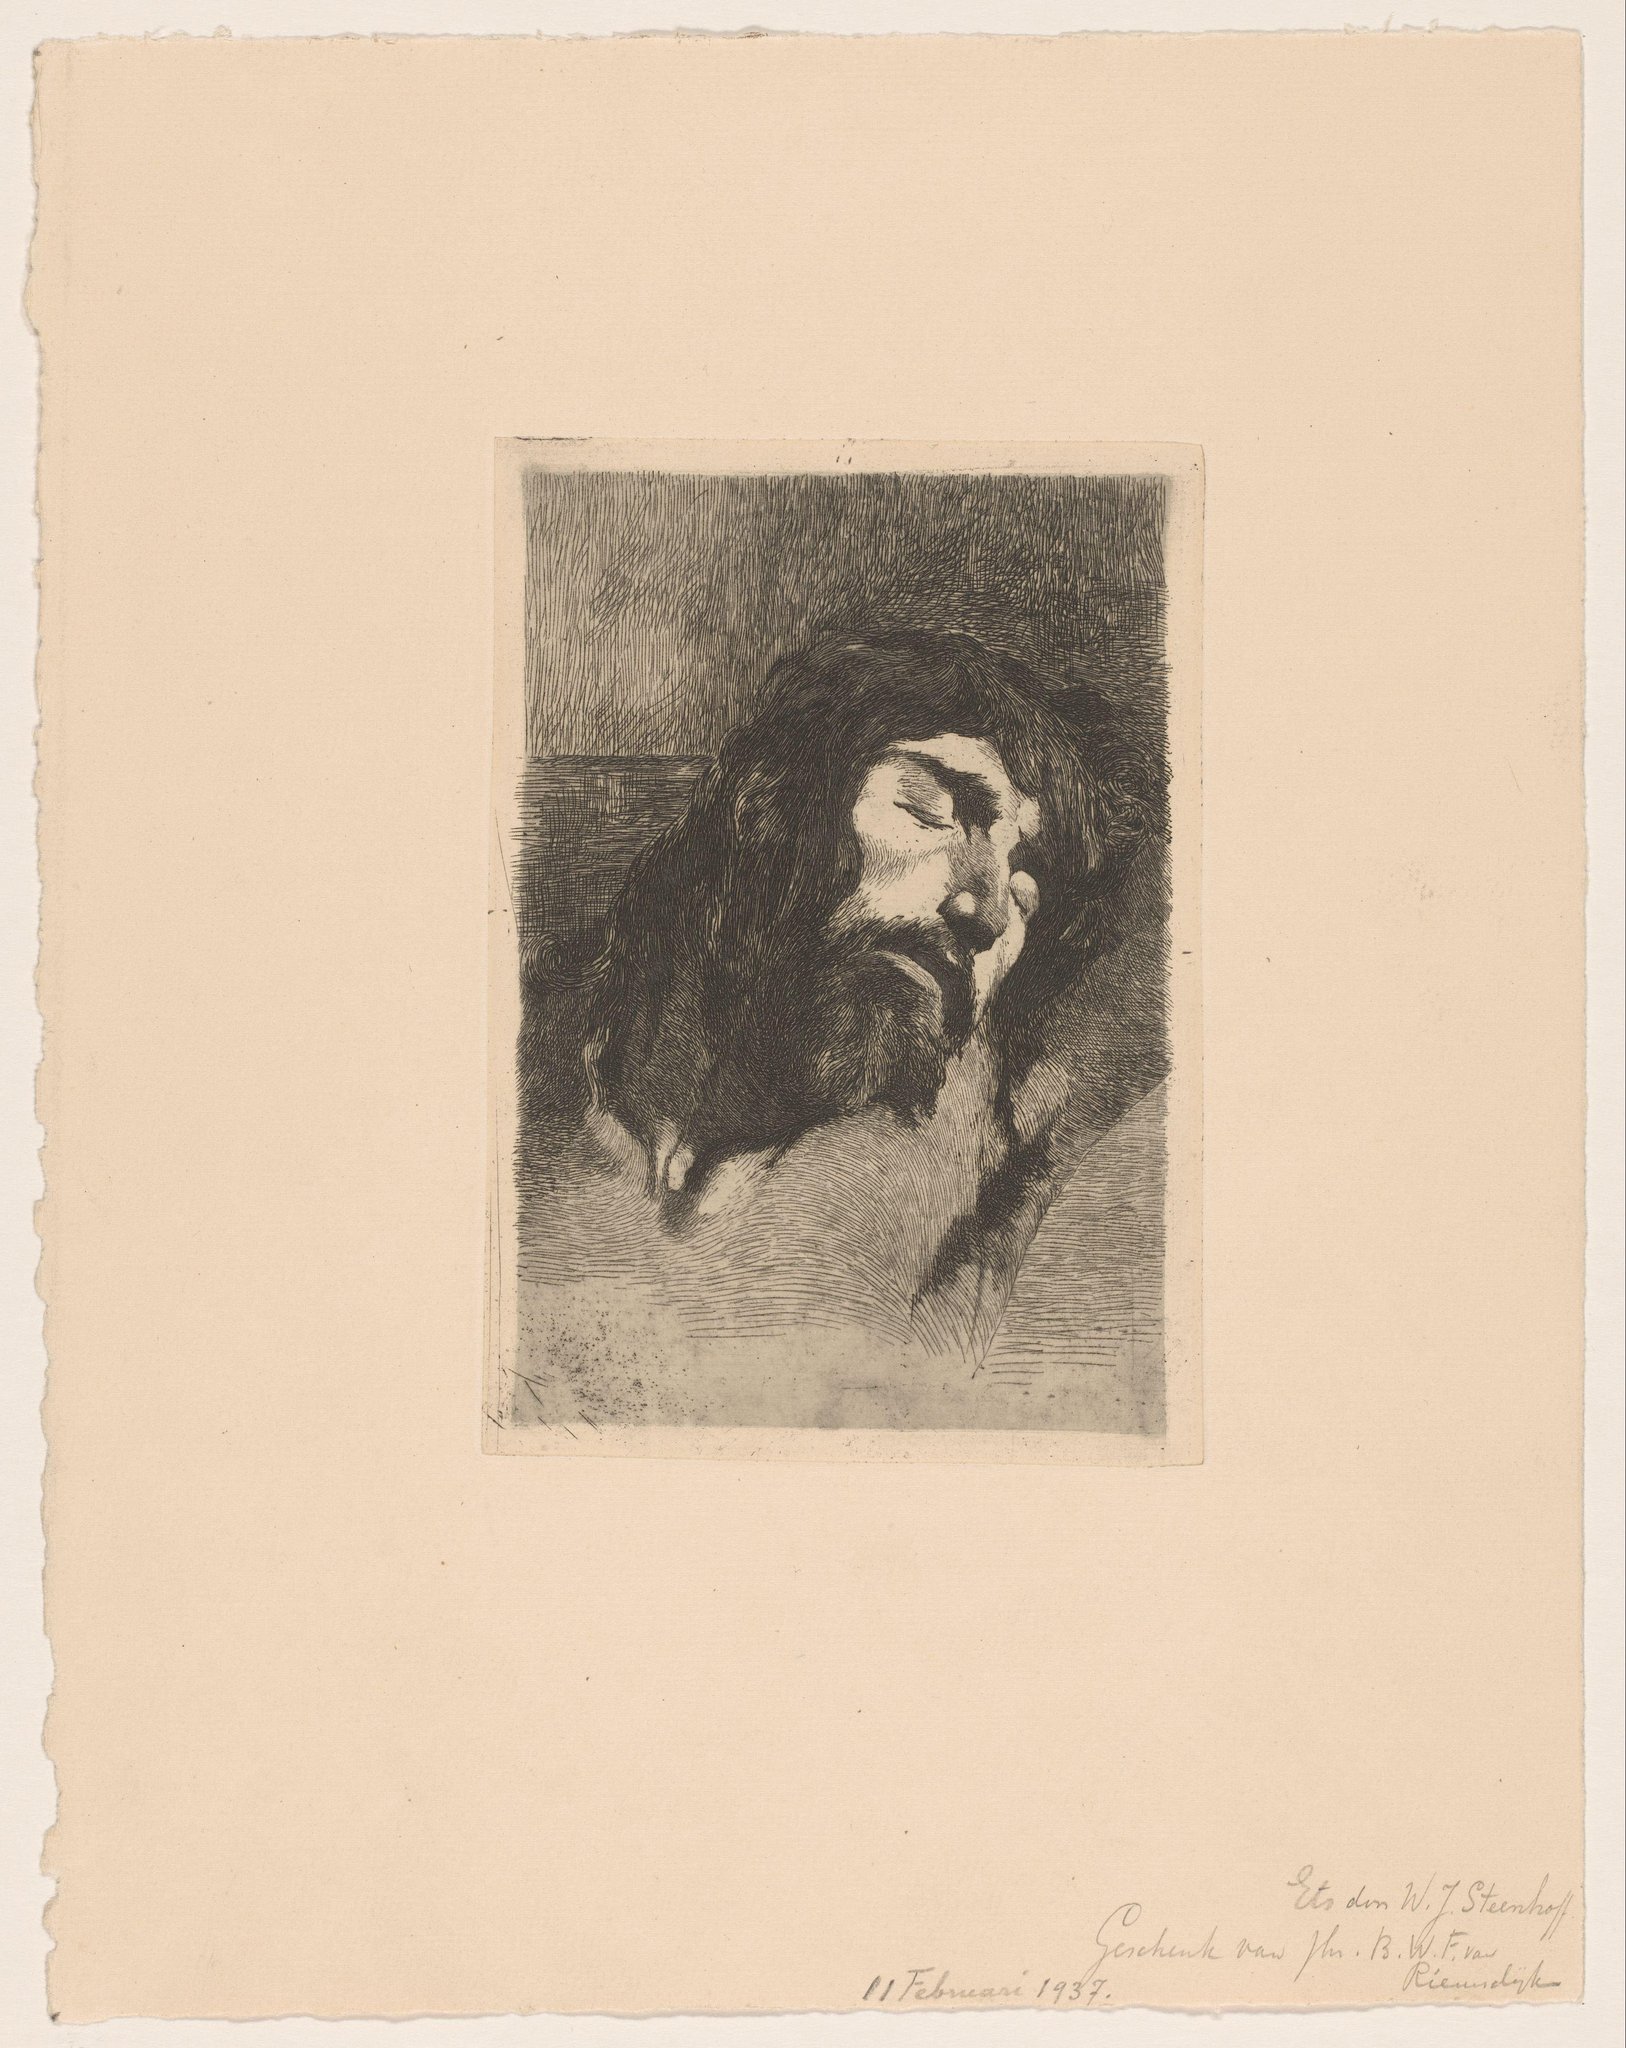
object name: print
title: Christus met gesloten ogen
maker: wilhelmus johannes steenhoff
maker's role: draughtsman, print maker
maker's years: 1863-1932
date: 1873-1932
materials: paper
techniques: etching, intaglio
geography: netherlands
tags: eyes closed, 'portraits' of christ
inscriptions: collector's mark: Lugt 2228, inscription: ‘Ets van W.J. Steenhoff Geschenk van Jhr. B.W. F. van Riemsdijk 11 Februari 1937’